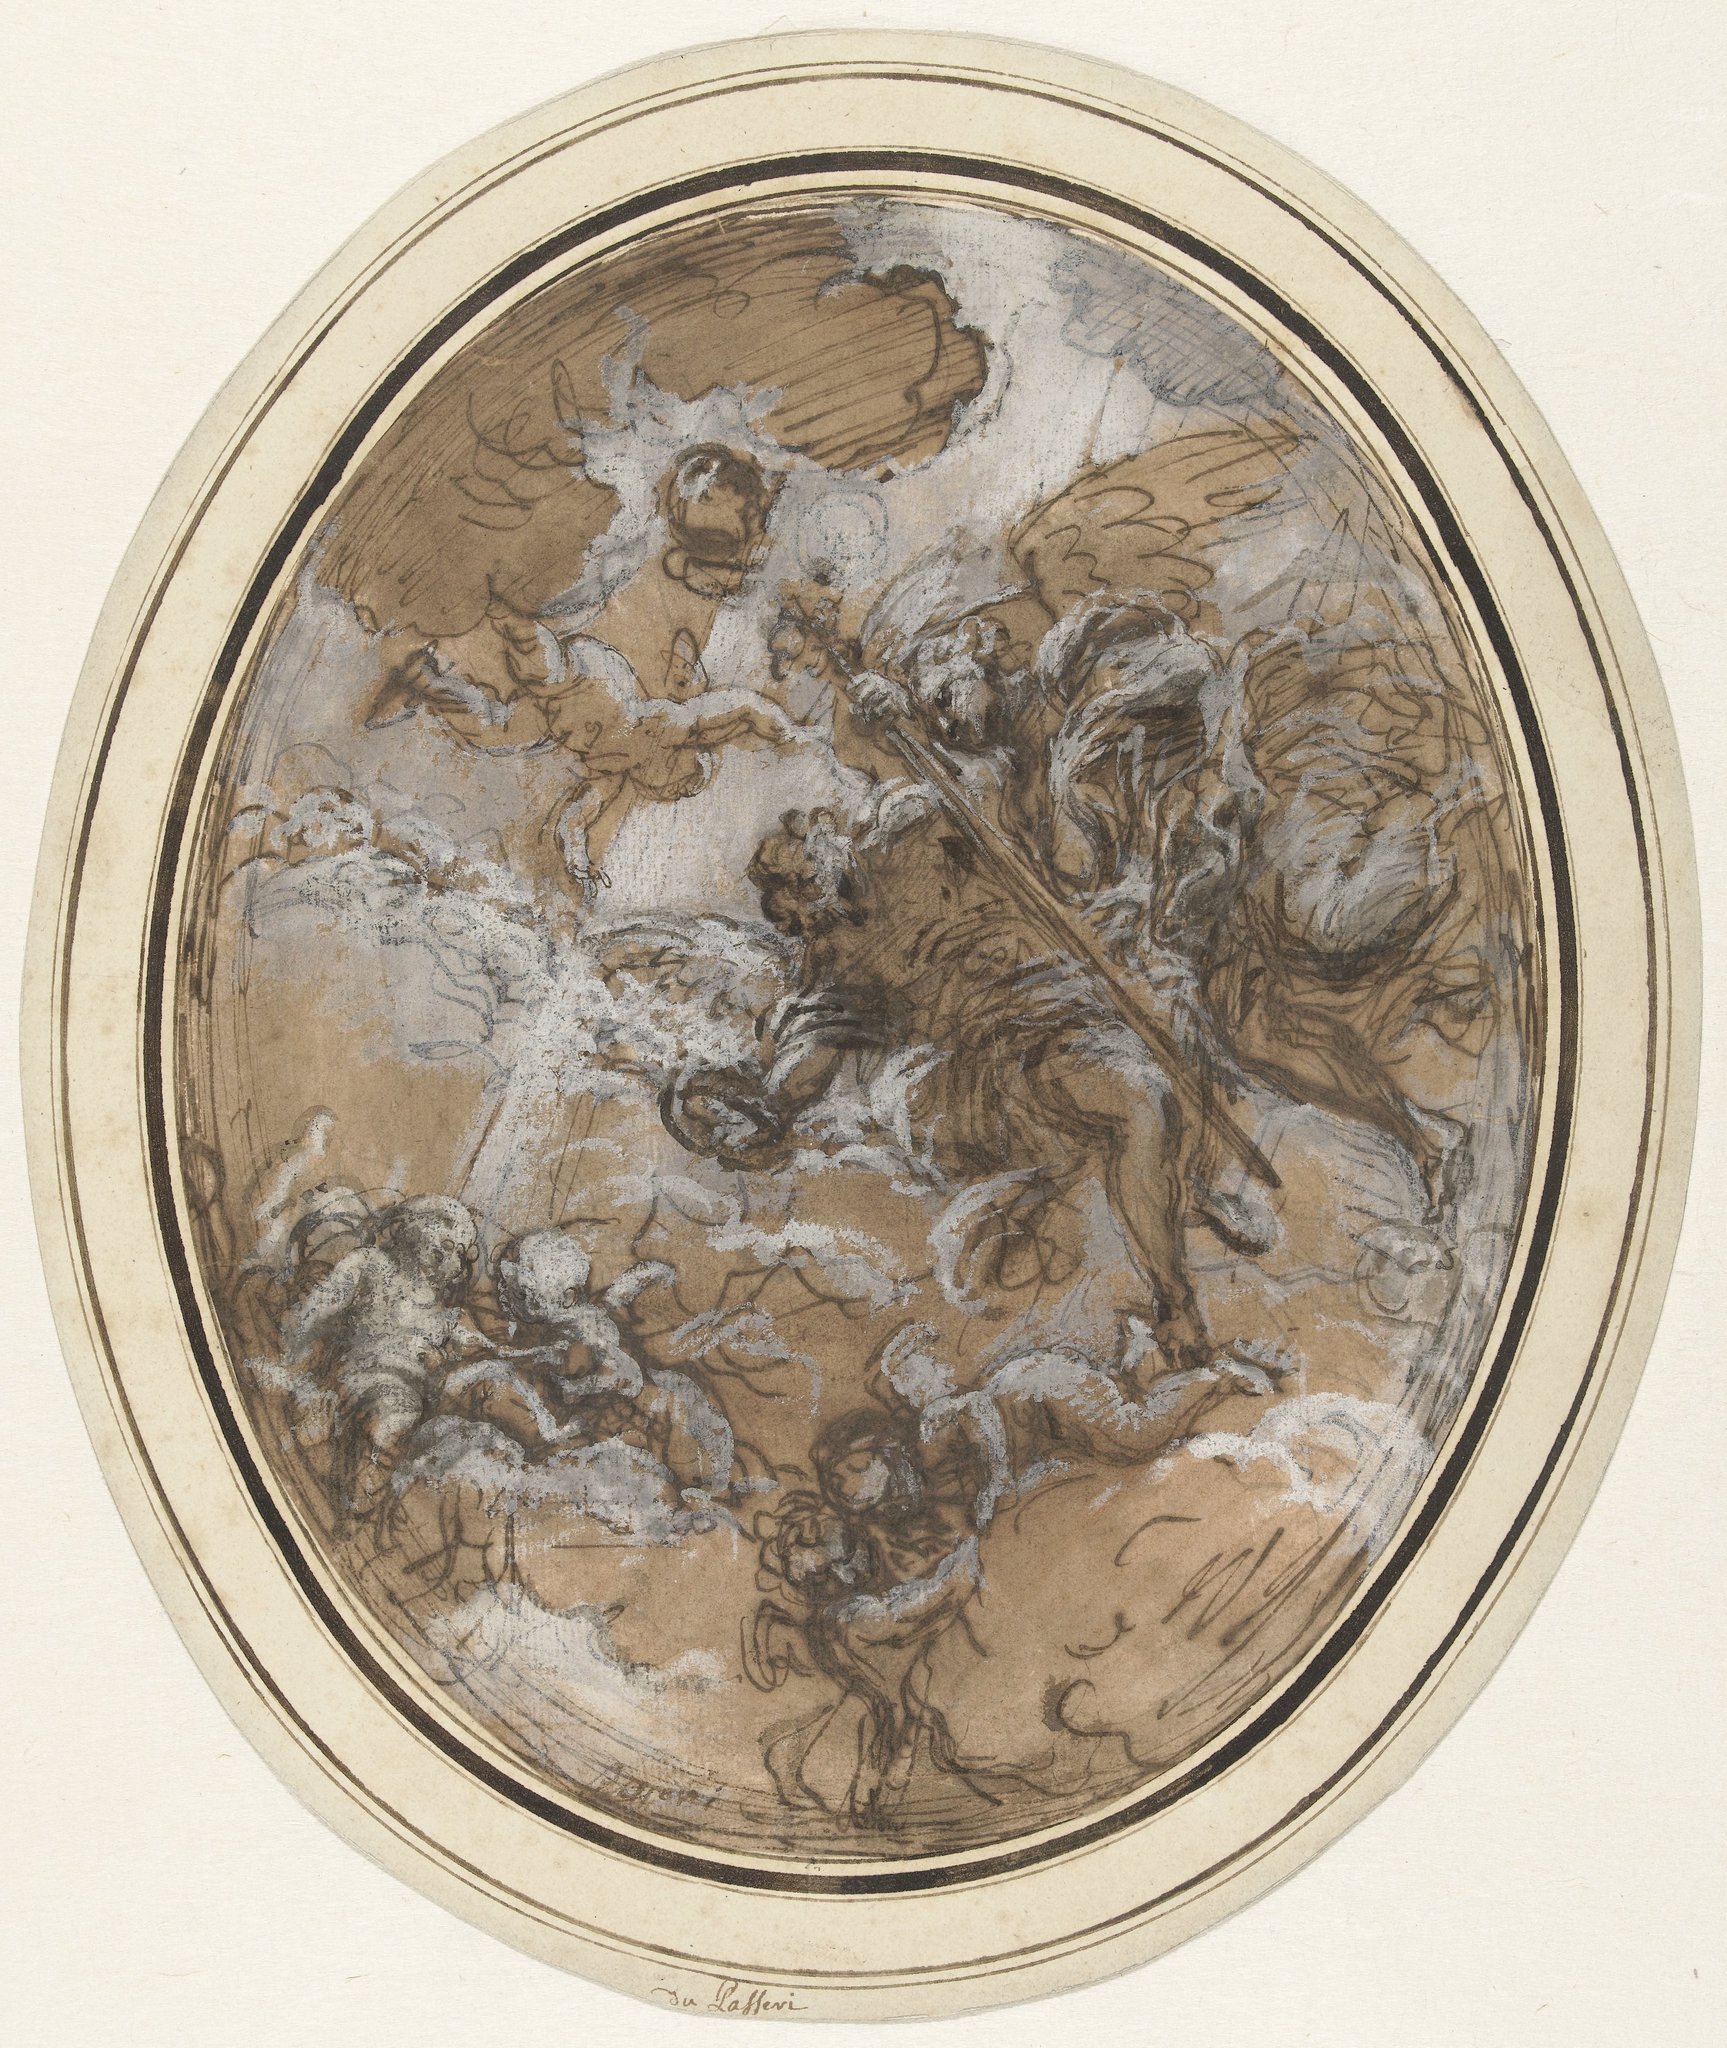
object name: drawing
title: Glorification of St Joseph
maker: giuseppe passeri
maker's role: draughtsman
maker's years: 1654-1714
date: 1664-1714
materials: chalk, paint, ink, paper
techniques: pen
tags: st. joseph as foster-father of christ, holding the child in his arms or leading him by the hand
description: The draughtsmanship of Giuseppe Passeri – Maratti’s favourite pupil, whose work hangs alongside here – is swift, almost impatient. He set everything in motion. This infectious delight in drawing resulted in hundreds of preliminary studies for frescoes and oil paintings. This oval sketch was probably a design for a ceiling. In the clouds, St Joseph, surrounded by putti, ascends with Christ to heaven.